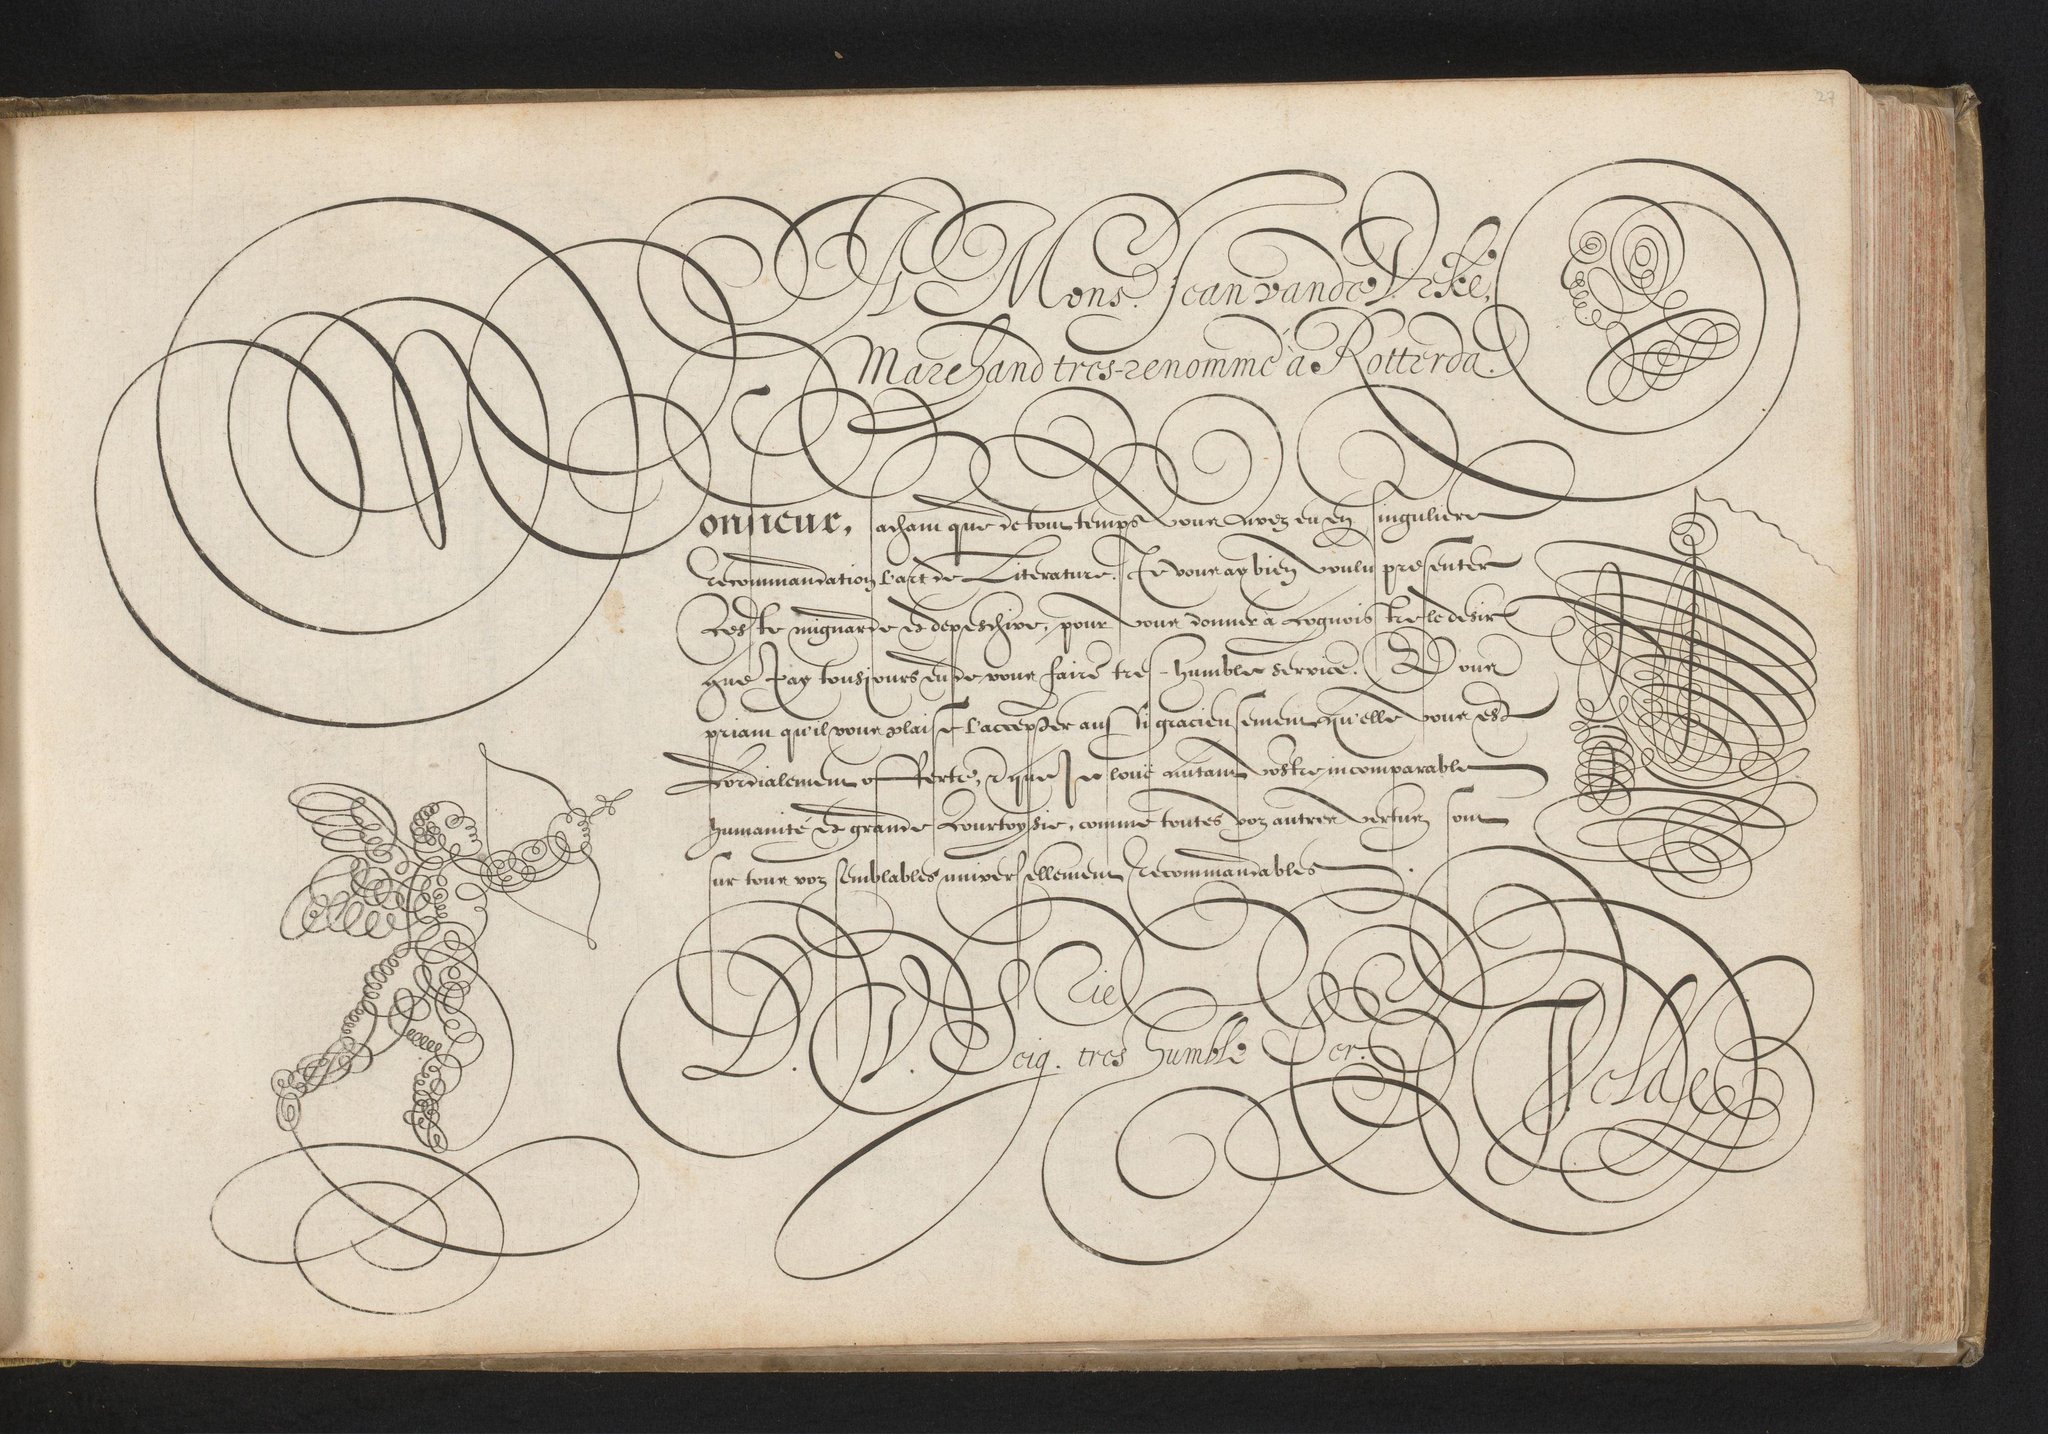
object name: album leaf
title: Schrijfvoorbeeld: A Mons. Jean van de Veke (...)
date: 1605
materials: paper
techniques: engraving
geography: rotterdam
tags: head (human), ships (in general), calligraphy, cupids: 'amores', 'amoretti', 'putti'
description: Schrijfvoorbeeld met de aanhef: A Mons. Jean van de Veke. Marchand tres renomme à Rotterda(m). Daaronder in een andere letter een initiaal M en acht regels tekst in het Frans: Monsieur, sachant que de tous temps ... De tekst is omlijst door krulwerk, met naast de aanhef een hoofd in krulwerk, linksonder Amor en midden rechts een schip. De prent maakt deel uit van een album.